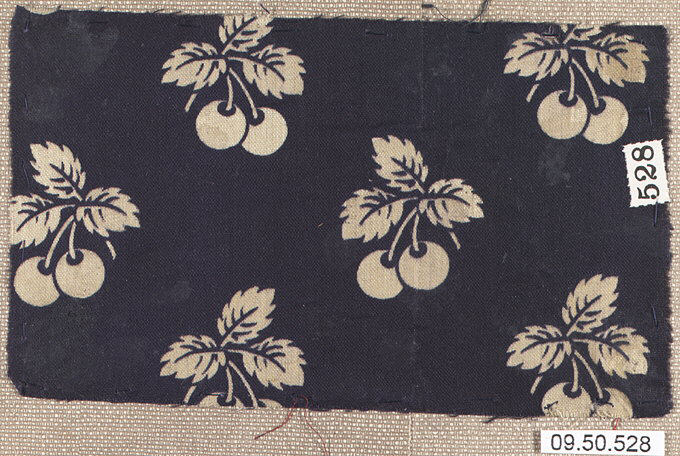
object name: piece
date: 1801-1900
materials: cotton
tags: fruit,leaves